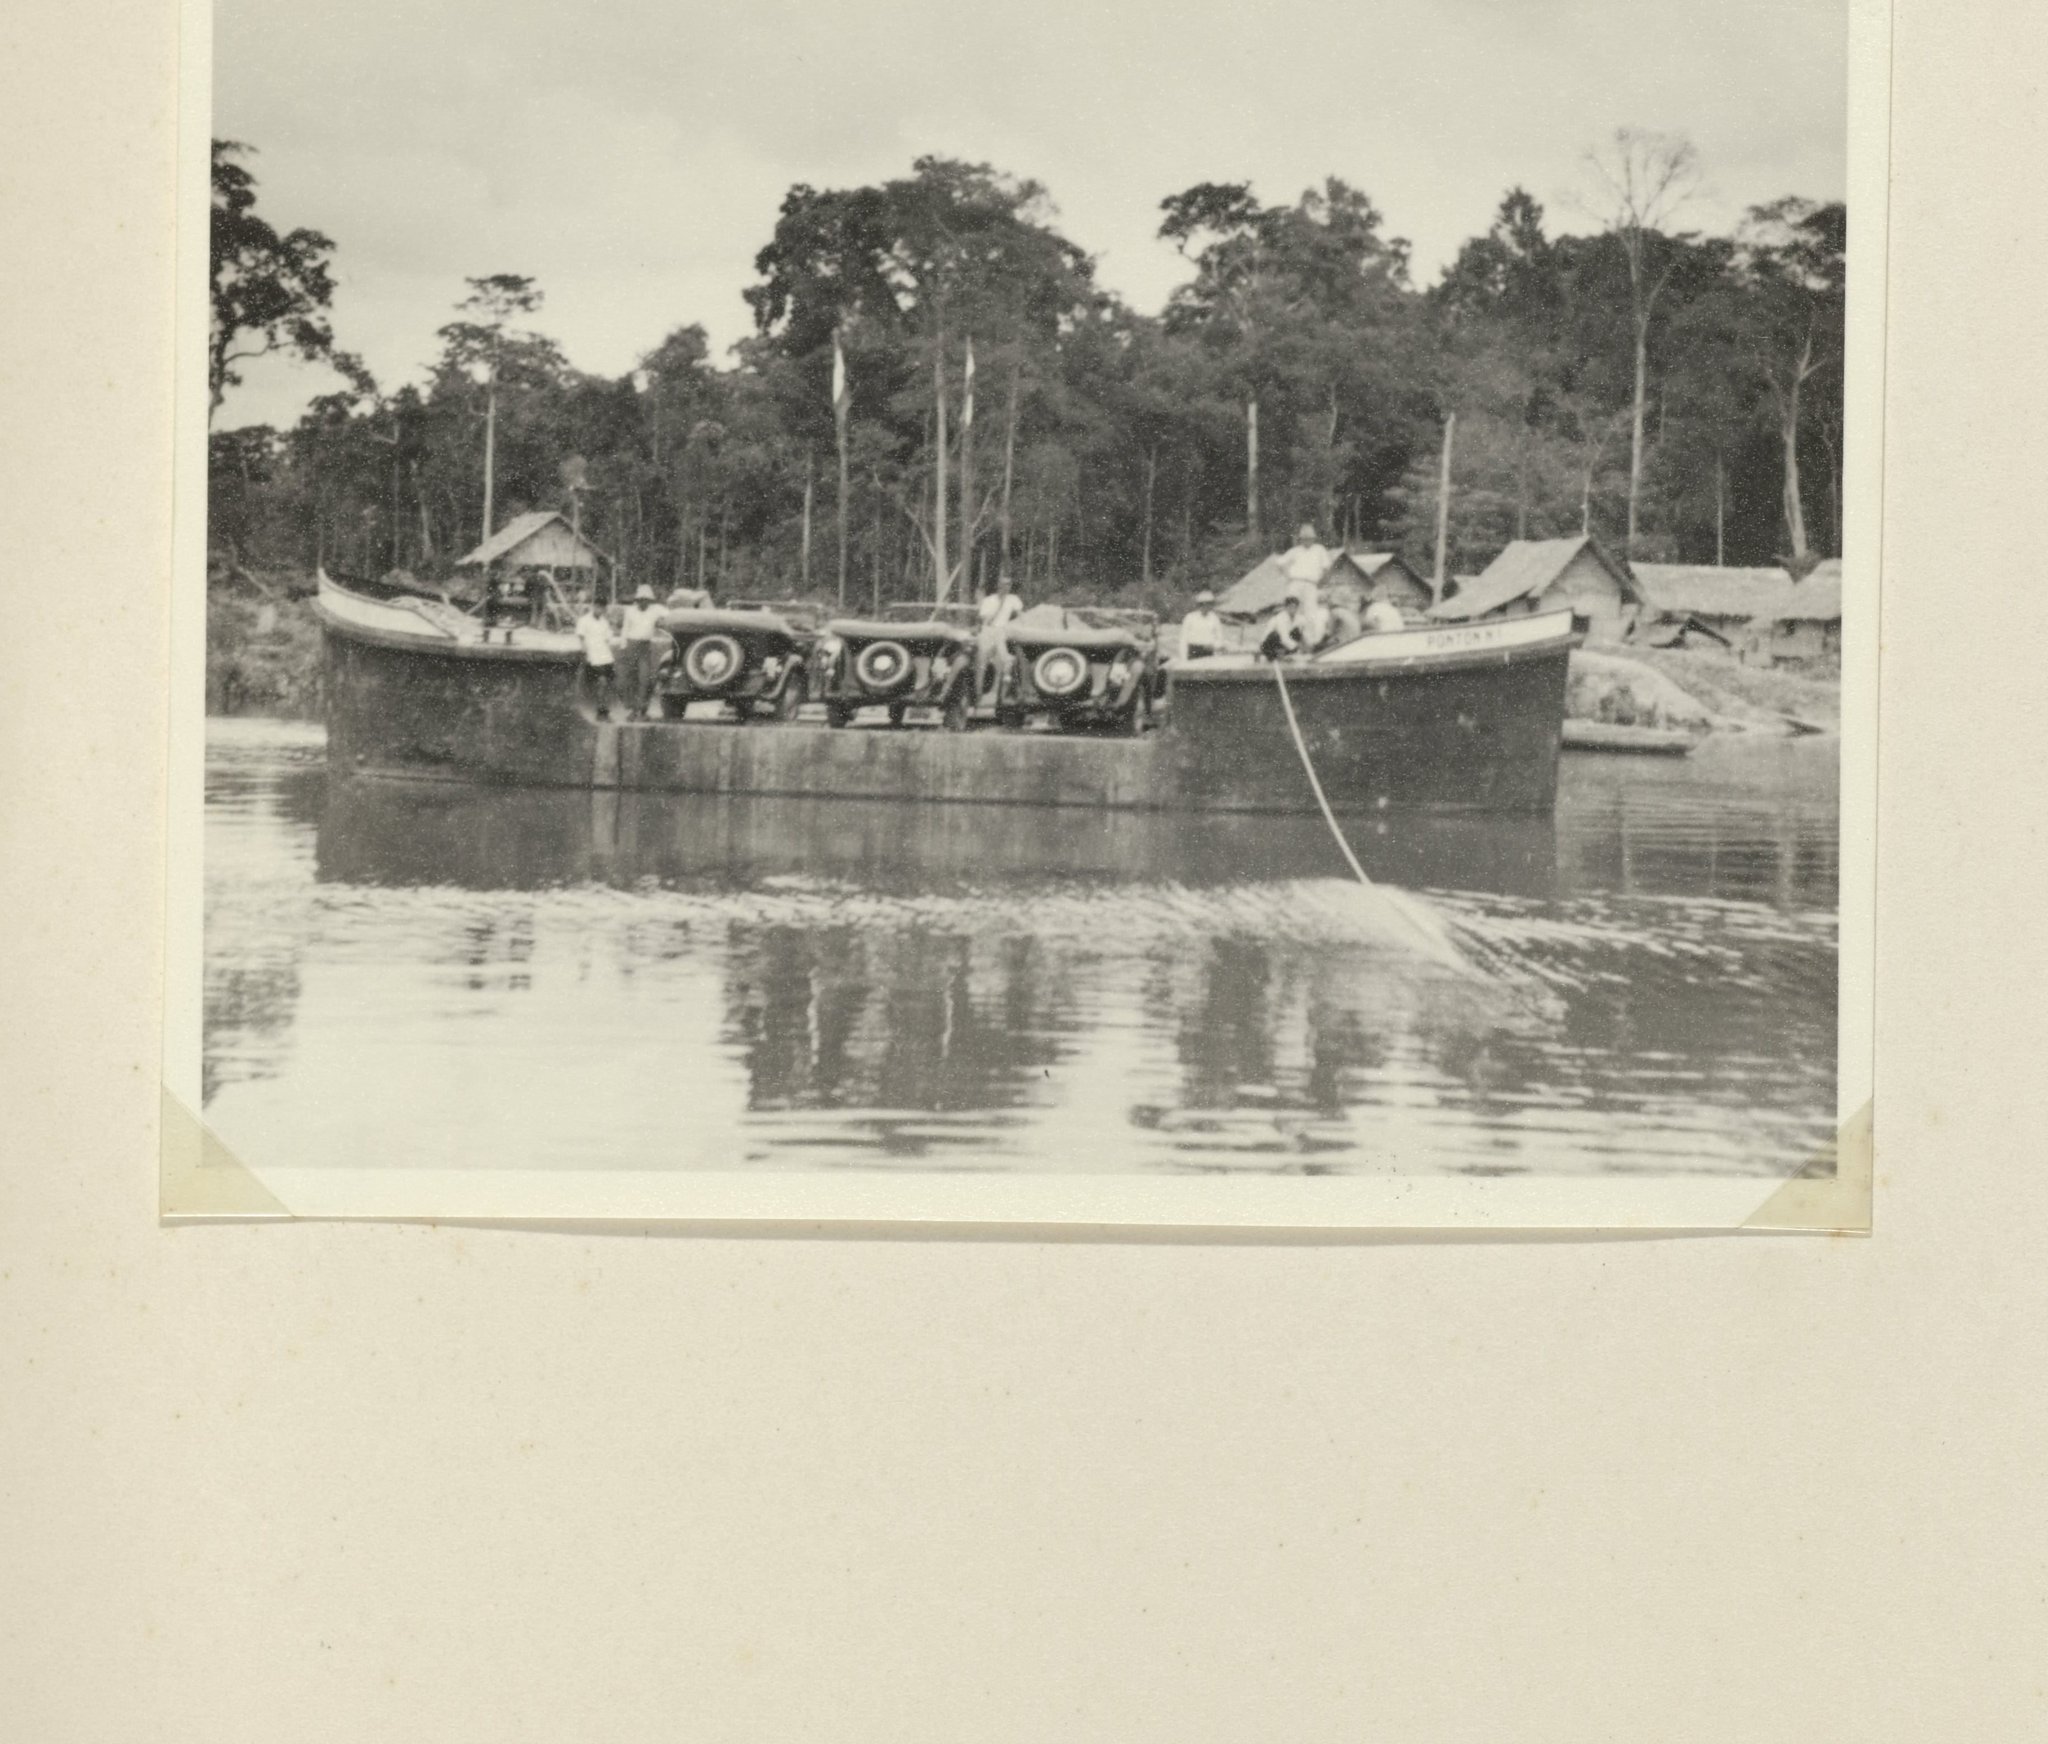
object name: photograph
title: Overzetten van drie auto's op een veerboot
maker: Anonymous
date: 1935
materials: photographic support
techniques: gelatin silver print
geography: sumatra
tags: utrecht, germany, colonial system, pipeline ~transportation of oil, ferry, commemoration, jubilee, automobile, sumatra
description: Het overzetten van drie auto's van genodigden op een veerboot. Foto in het fotoalbum samengesteld ter gelegenheid van de feestelijke ingebruikstelling van de pijpleiding van Tempino naar Pladjoe op Sumatra door de Nederlandsch-Indische Aardolie Maatschappij (NIAM) op 15 november 1935.